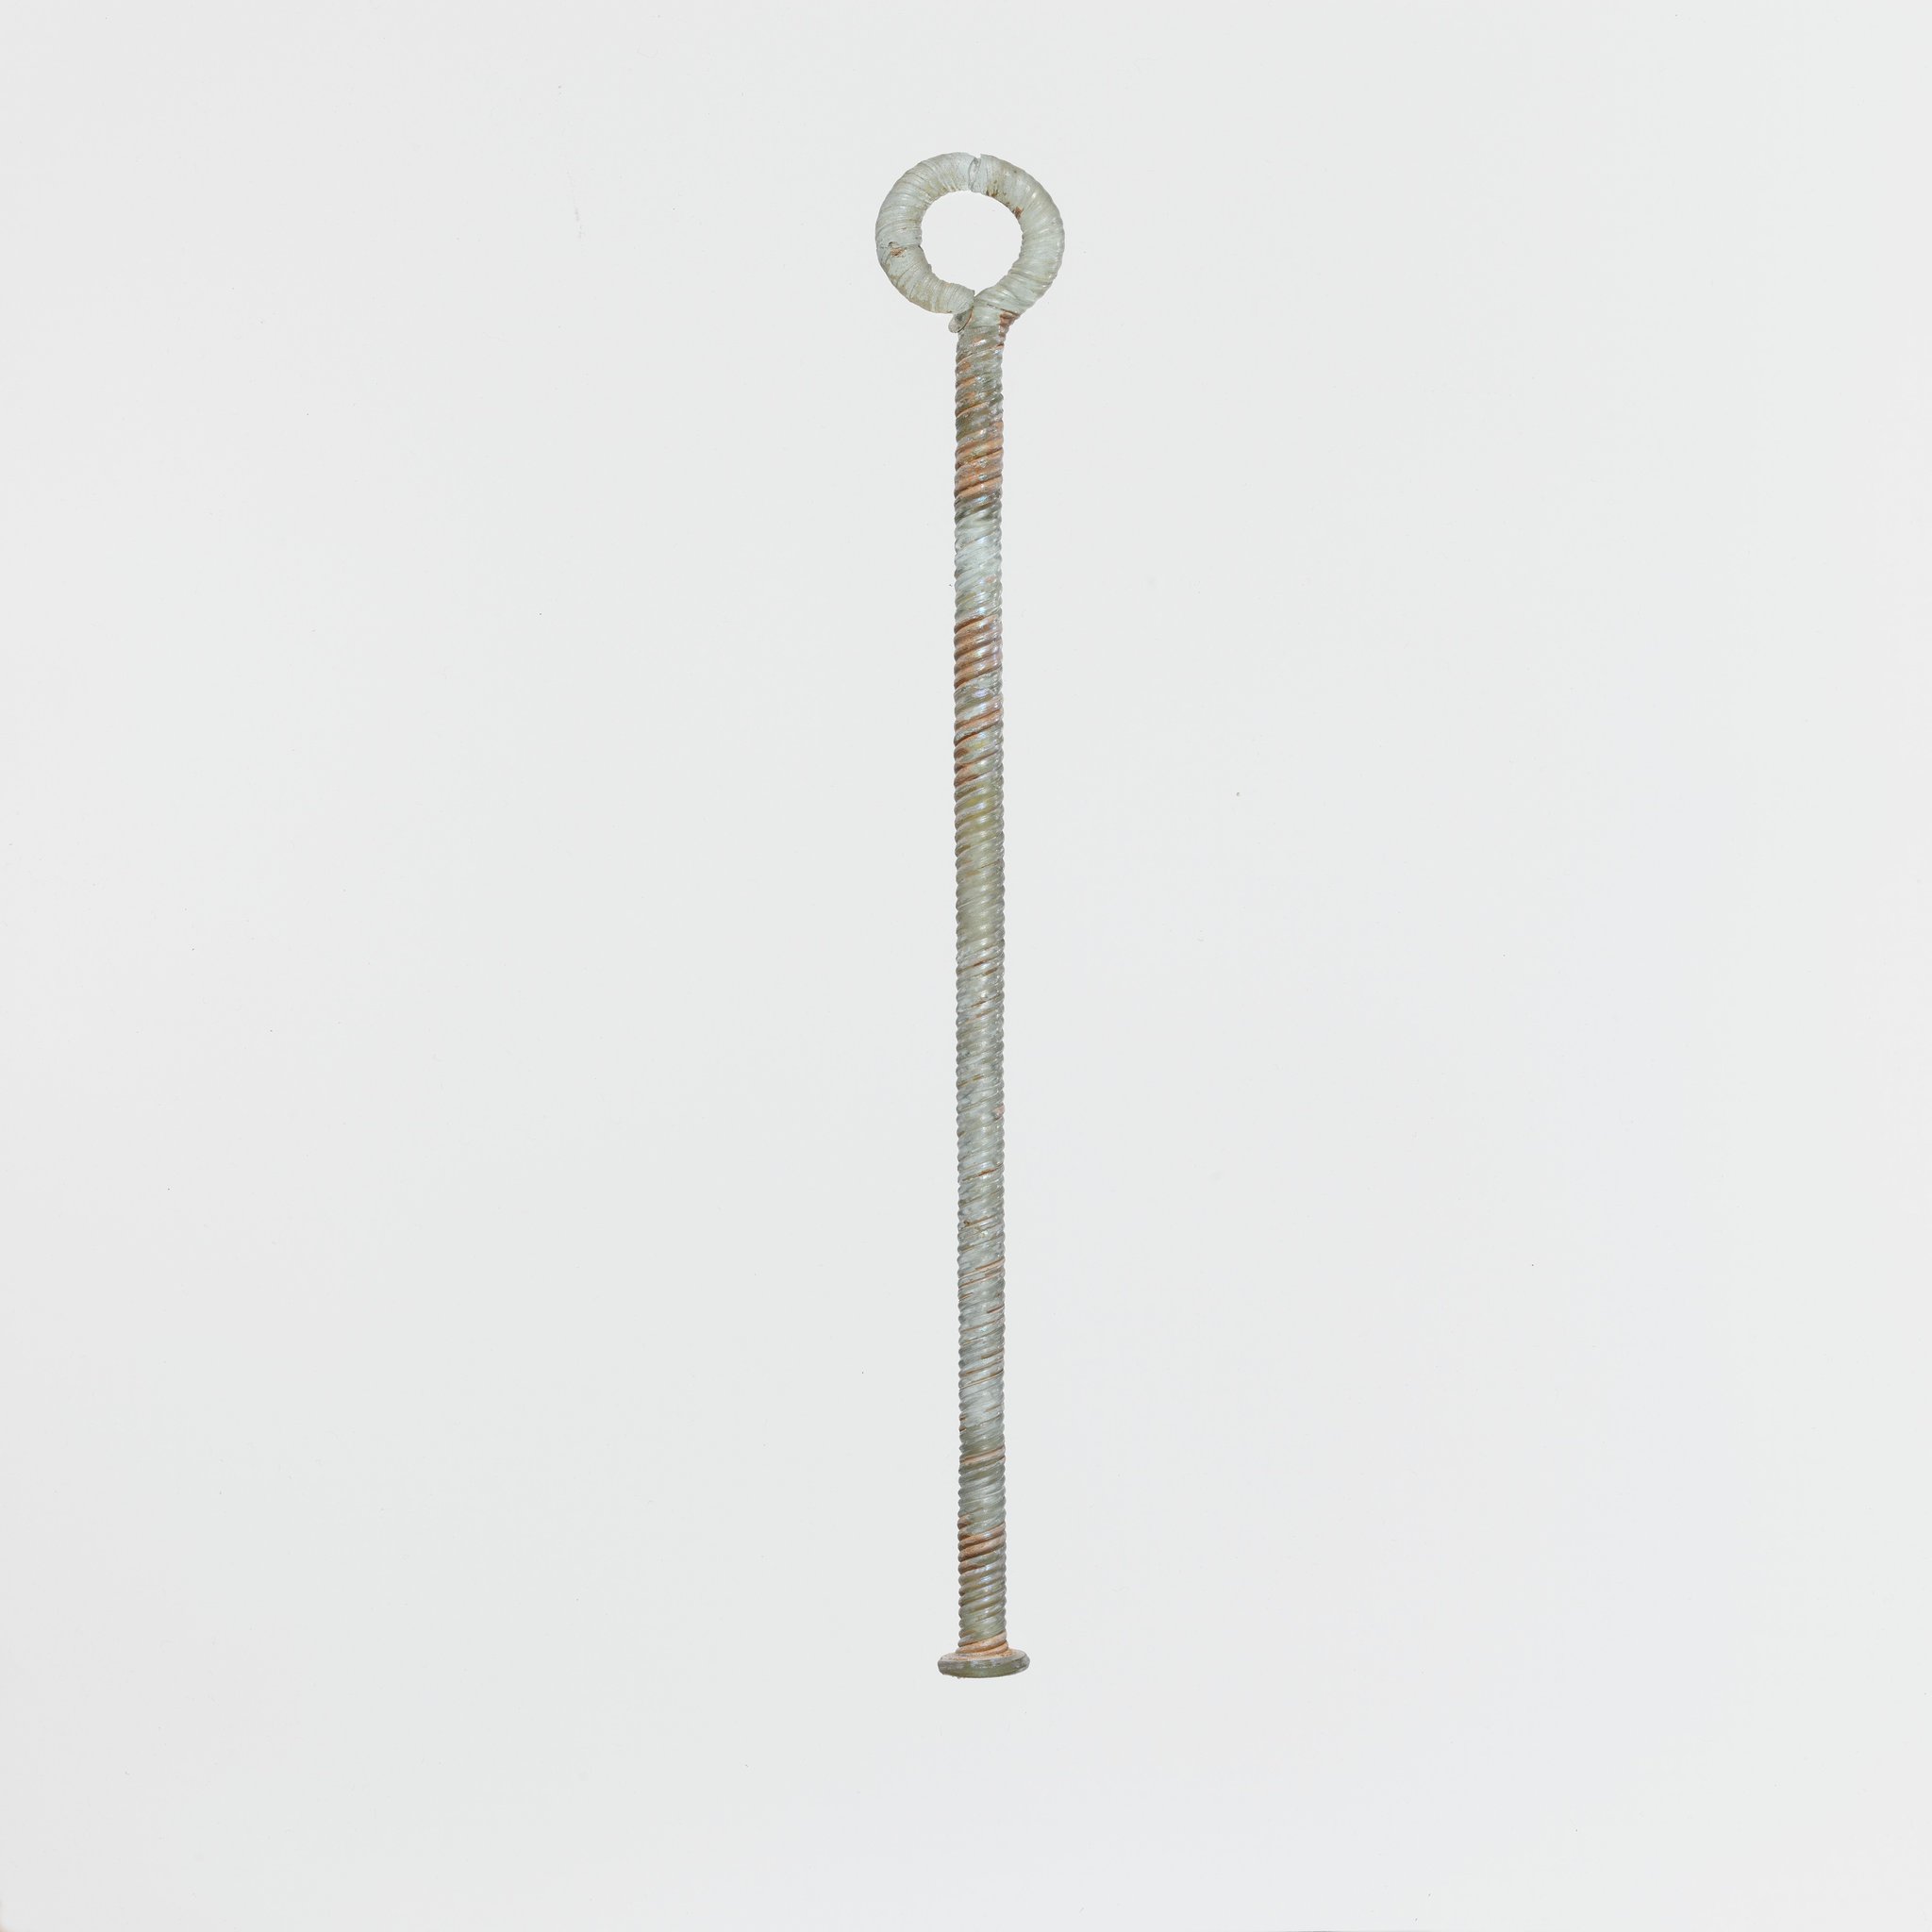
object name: stirring rod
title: Glass stirring rod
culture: roman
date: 1-200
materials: glass